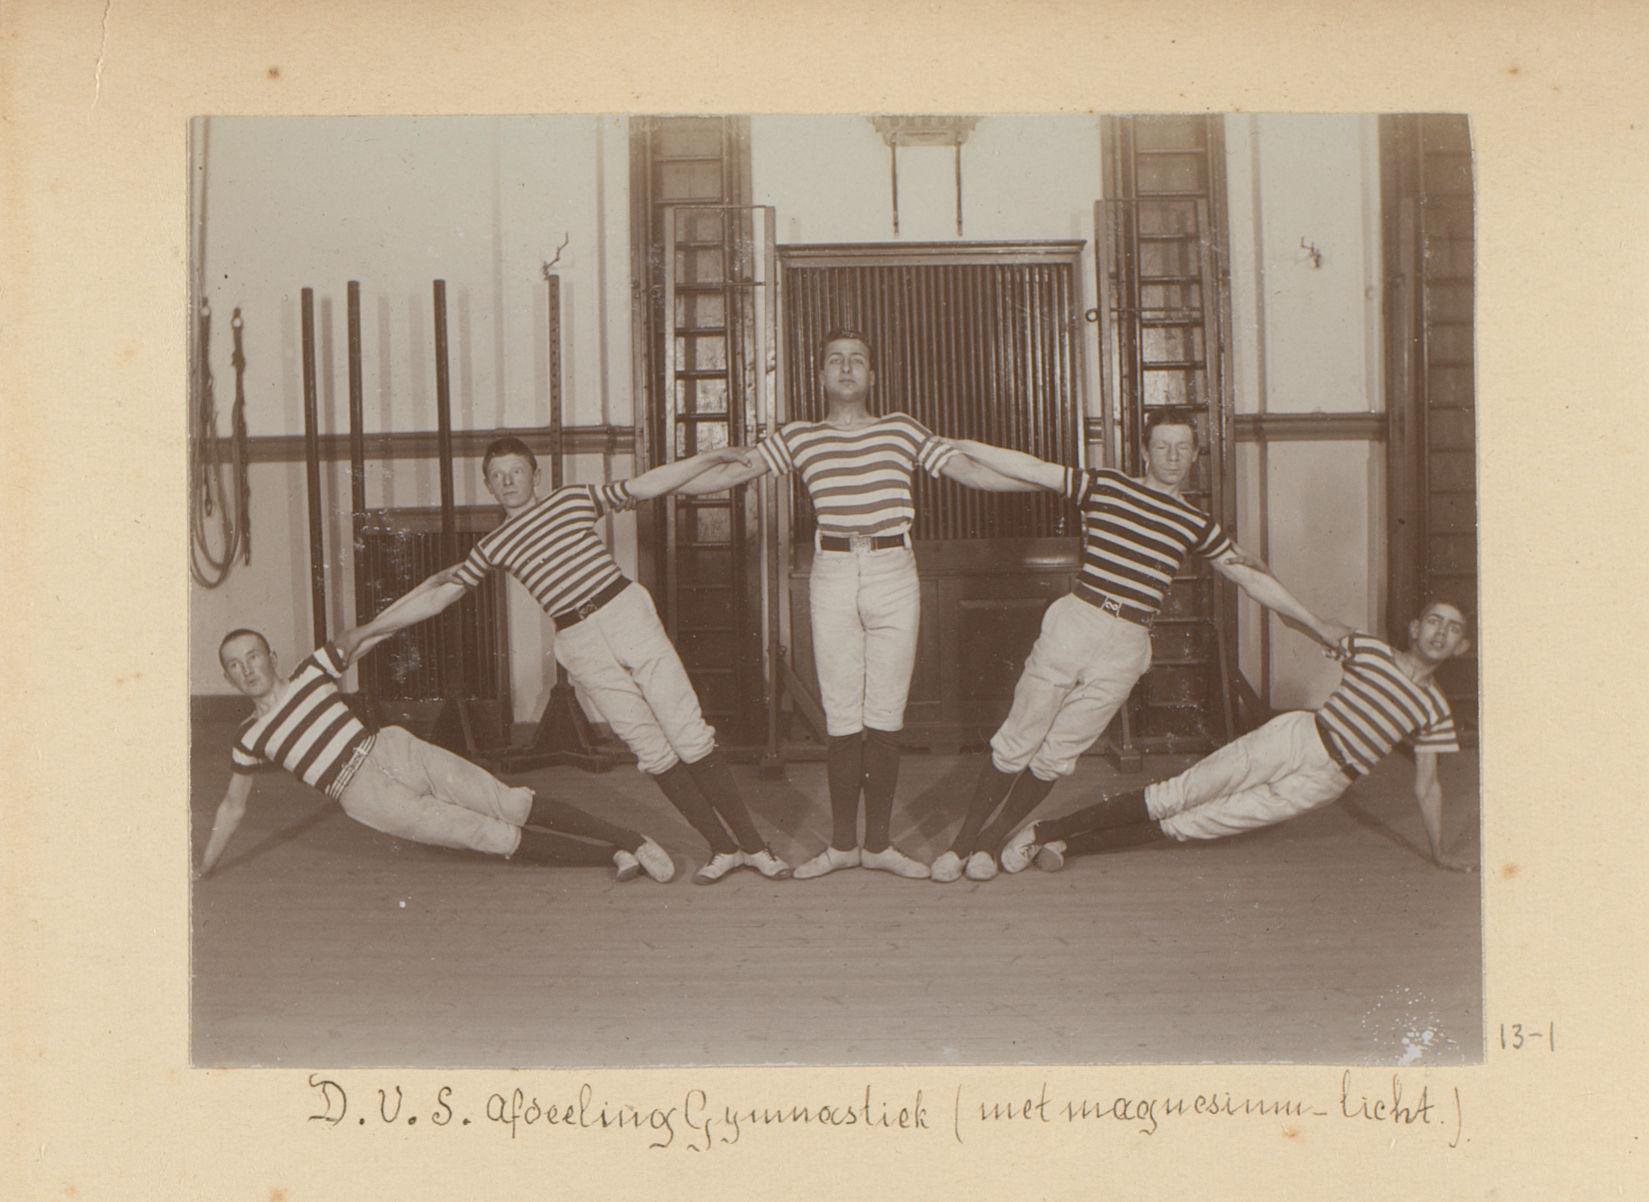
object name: album leaf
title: Gymnastiek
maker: hendrik herman van den berg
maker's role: amateurfotograaf, jurist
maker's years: 1875-1944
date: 1890-1894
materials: paper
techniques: collodion silver print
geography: amsterdam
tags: gymnastic exercises on the ground, historical persons, amsterdam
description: De foto is gemaakt bij flitslicht afkomstig van bliksempoeder.